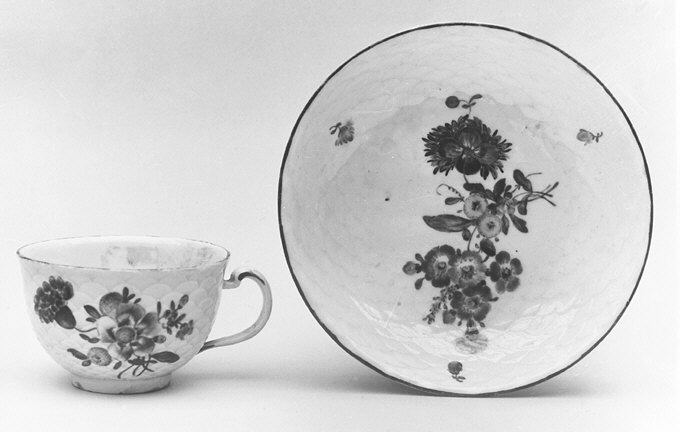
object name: cup and saucer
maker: ludwigsburg porcelain manufactory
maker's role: manufactory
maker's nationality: german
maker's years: 1758-1824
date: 1760-1770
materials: hard paste porcelain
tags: flowers